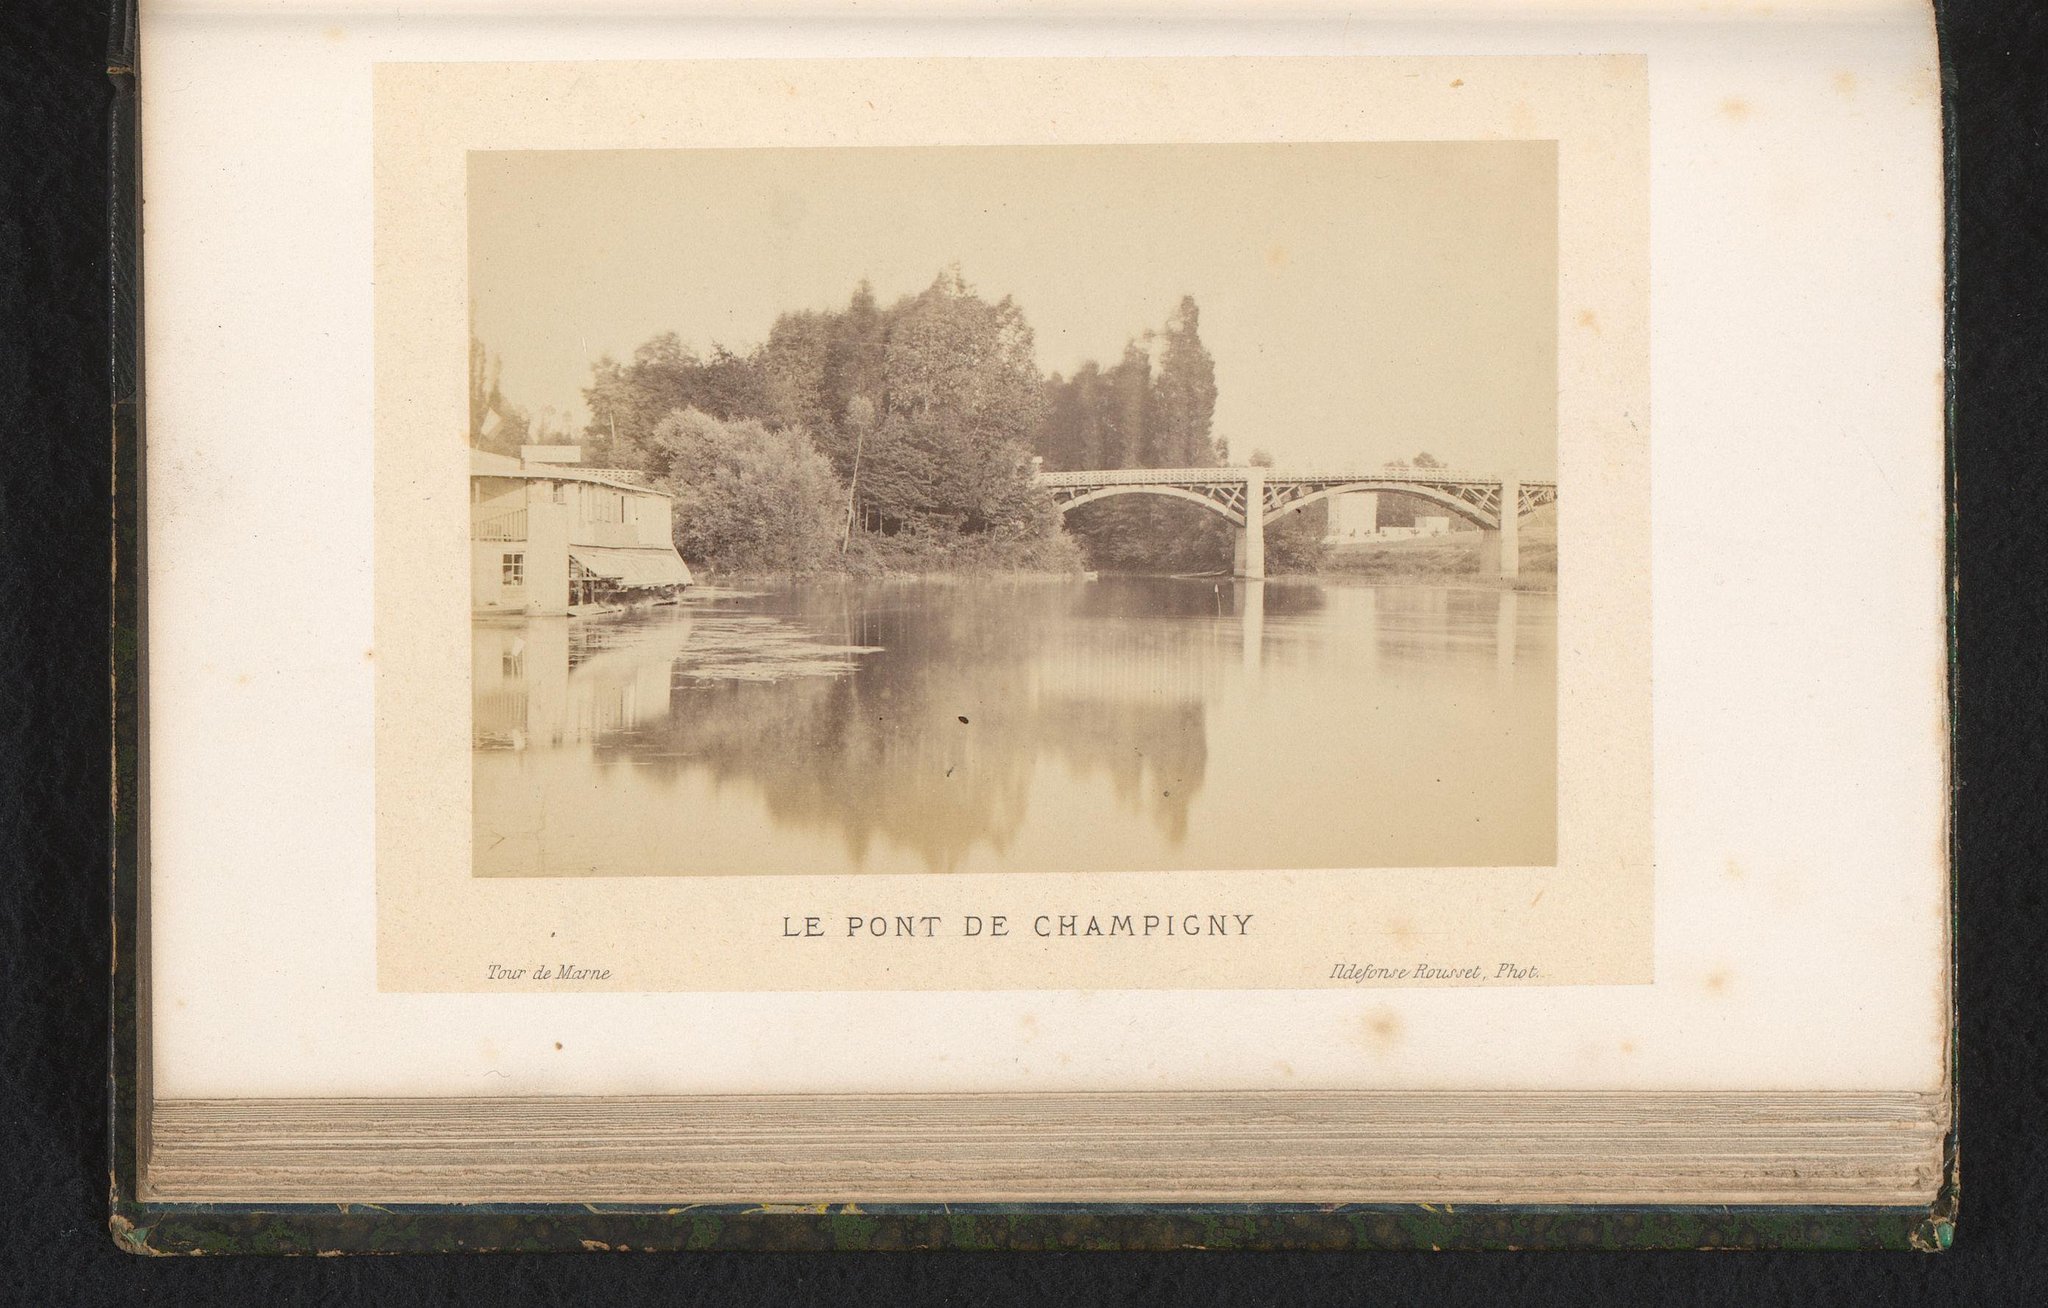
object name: page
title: Gezicht op de Marne bij Champigny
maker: ildefonse rousset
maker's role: fotograaf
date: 1860-1865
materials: paper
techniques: albumen print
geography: champigny-sur-marne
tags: river, bridge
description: Foto op ongenummerde pagina tegenover pagina 71.